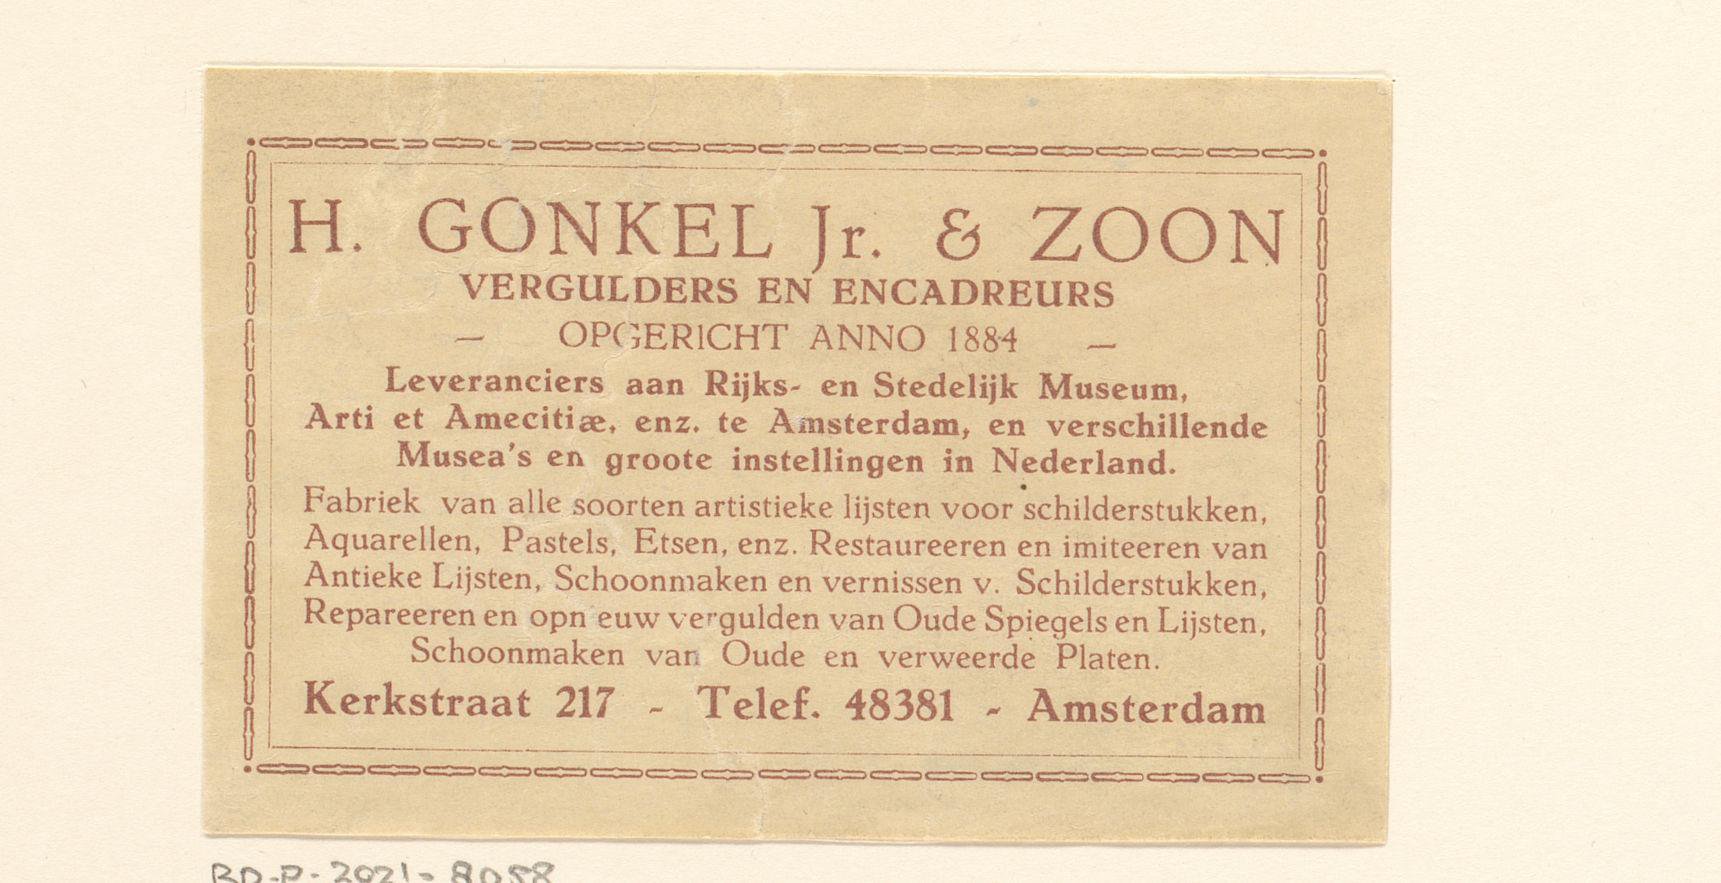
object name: label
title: Etiket van lijstenmaker H. Gonkel Jr. & Zoon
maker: Anonymous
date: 1900-1950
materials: paper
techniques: letterpress printing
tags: printed matter, amsterdam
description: Etiket met een beschrijvende tekst over de activiteiten van 'H. Gonkel Jr. & Zoon, vergulders en encadreurs' uit Amsterdam.